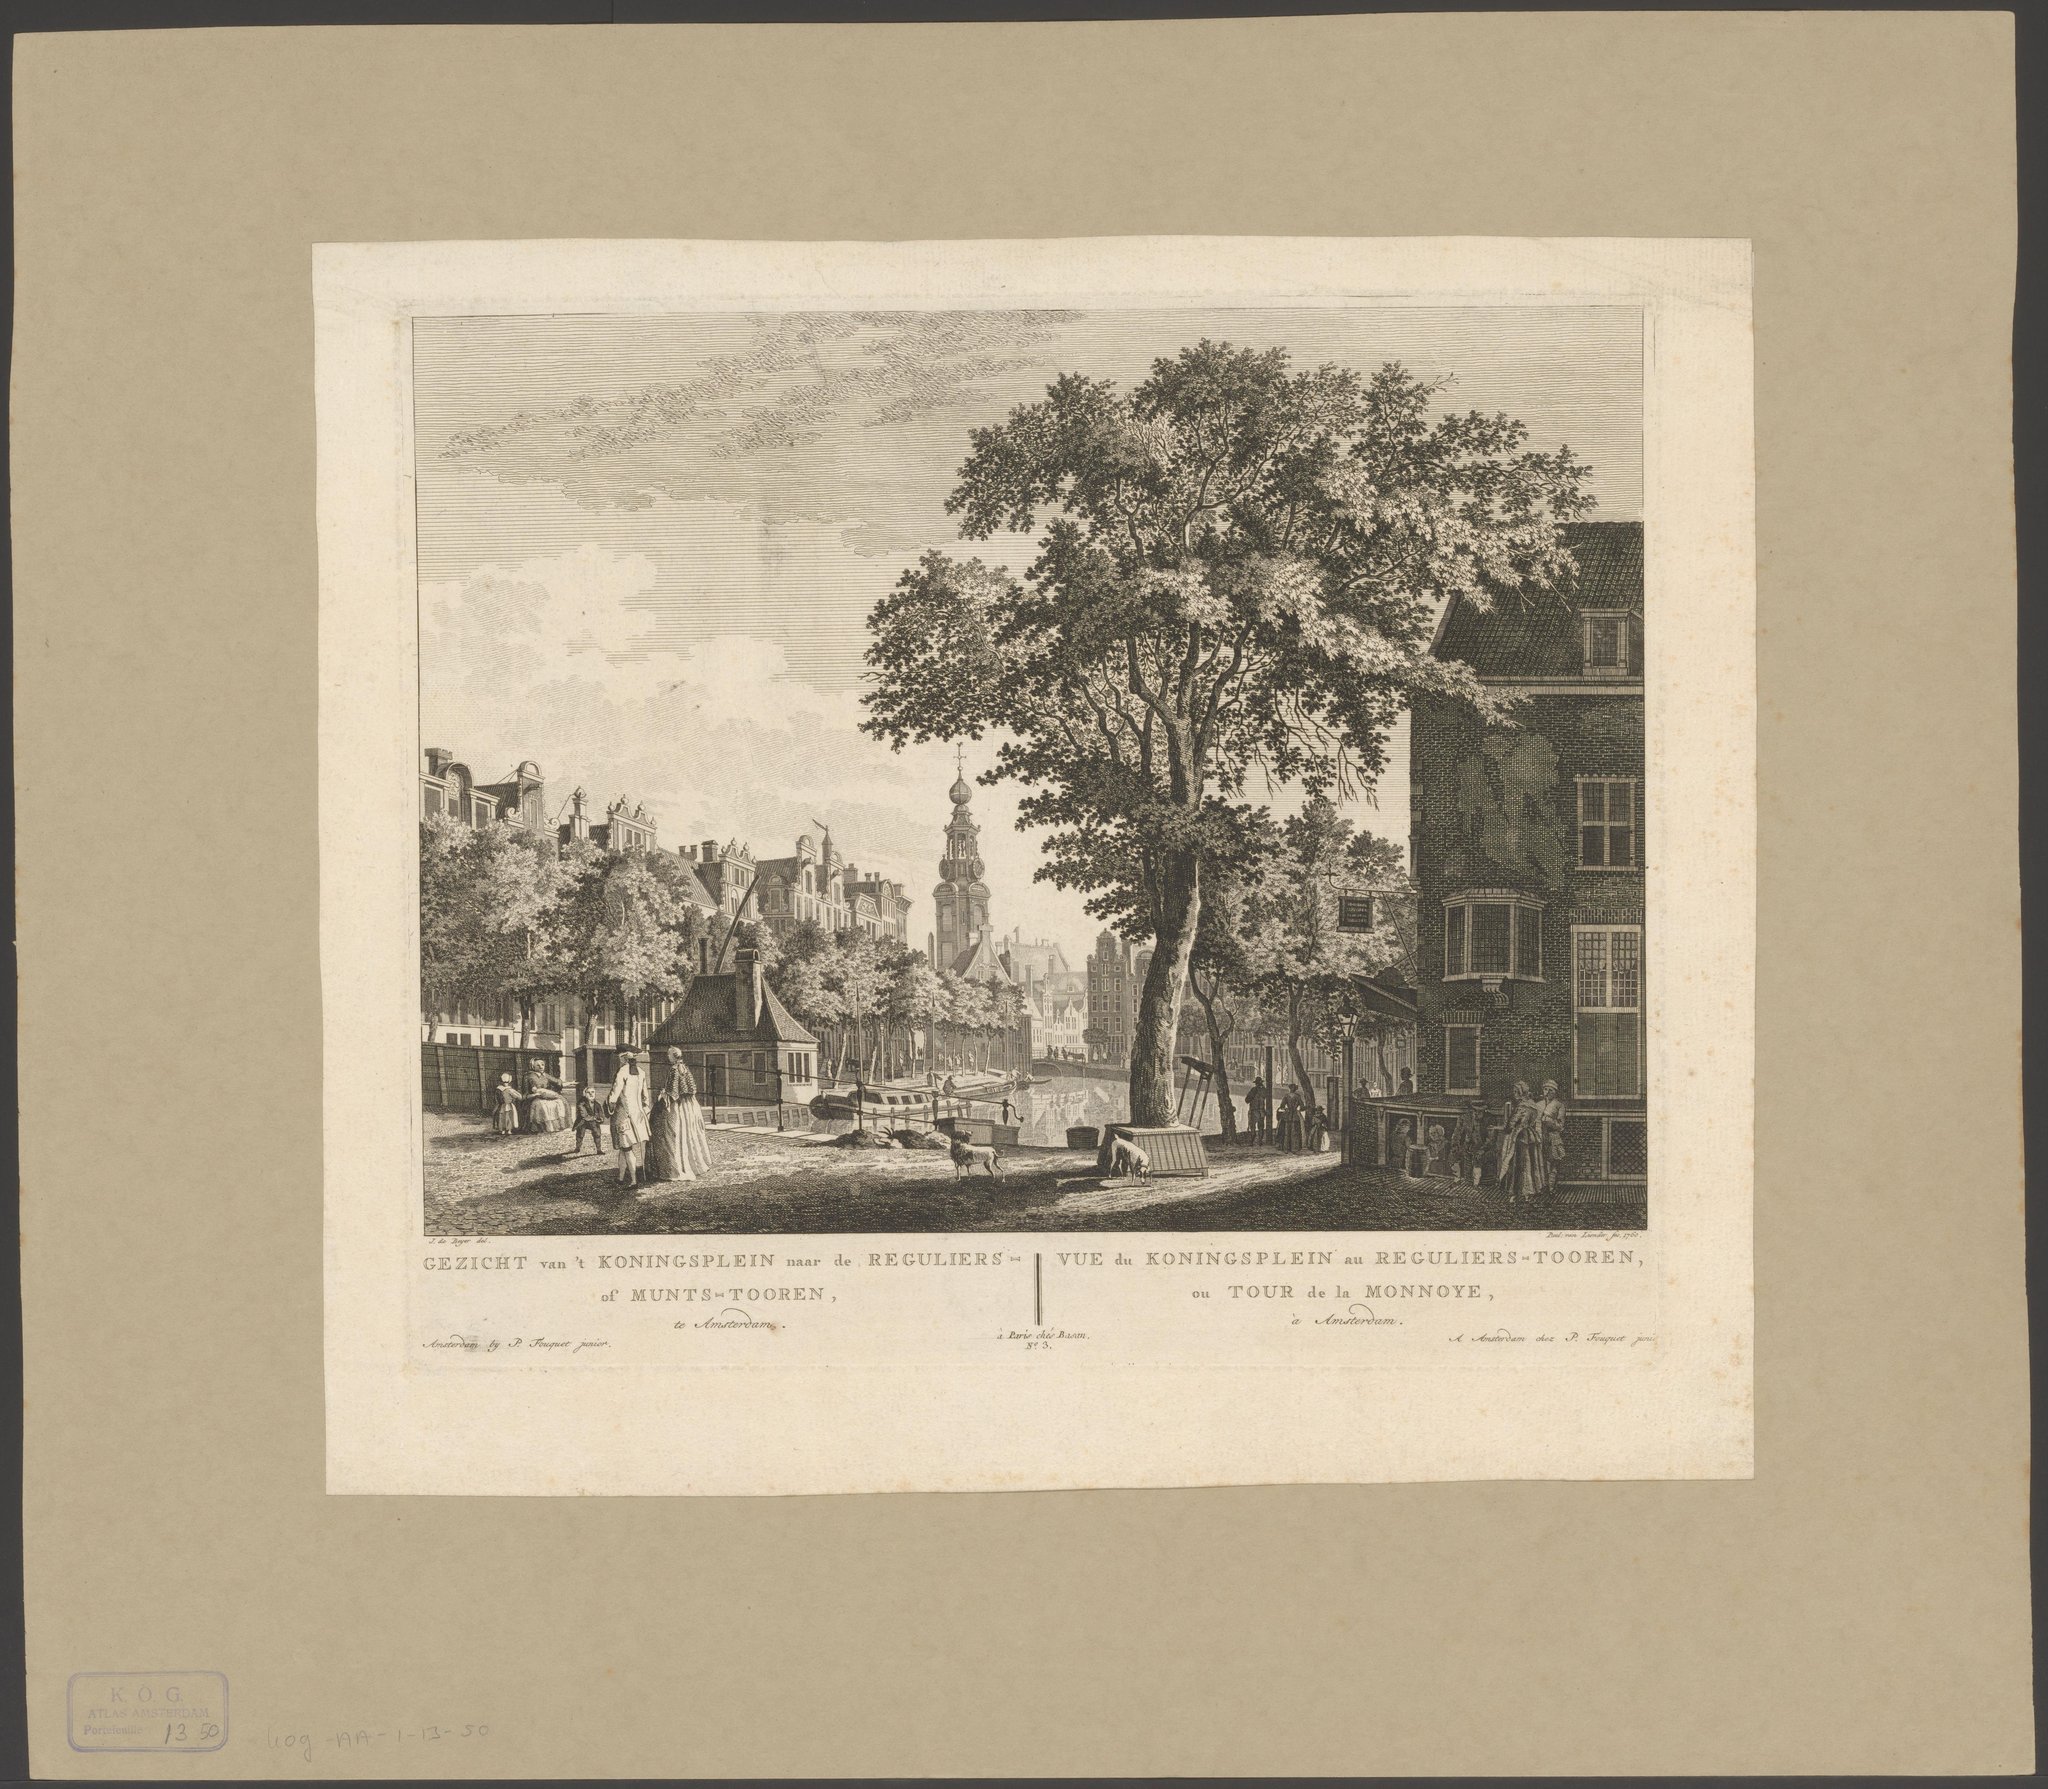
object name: print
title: Gezicht op de Munttoren van het Koningsplein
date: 1760-1783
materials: paper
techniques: etching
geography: amsterdam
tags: tower, clock tower ~ monumental adornment, city-view in general; 'veduta', canal, street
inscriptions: collector's mark: ‘13,50’ Lugt 1641b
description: Deze prent is ook gebruikt in de zogenaamde Atlas van Fouquet.* Pierre Fouquet gaf vanaf 1760 stadsgezichten van Amsterdam - naar tekeningen van verschillende kunstenaars, gemaakt door verschillende prentmakers - uit. Deze prenten werden aanvankelijk los of in series verkocht. Zoals toen gebruikelijk kon de koper de prenten zelf laten inbinden. Hiertoe gaf Fouquet tussen 1778 en 1783 een titelblad, plattegrond en inhoudsopgave van de tot dusver 100 uitgegeven prenten uit (1). Gezien de inhoud afhankelijk was van wat de koper had verzameld verschilt de inhoud van de verschillende bewaarde Fouquetatlassen onder deze titel sterk. Ook zijn er exemplaren bekend waar tevens andere prenten aan zijn toegevoegd. Omdat er behoefte bleek aan uitleg bij de platen werd in 1783 een nieuwe versie van de atlas uitgegeven, aangevuld met tekst en twee prenten. De aangegeven volgorde veranderde maar de platen van de al eerder uitgegeven prenten bleven ongewijzigd. Deze uitgave werd in opdracht van Fouquet gedrukt bij Daniël Jean Changuion en Petrus den Hengst (2). Een tiental platen werd bijgewerkt en verscheen, met nieuw impressum, in het vervolg van Wagenaars geschiedenis van Amsterdam, uitgeven door Petrus Conradi en Folkert van der Plaats (3). Een aantal jaar na het overlijden van Fouquet kwam Evert Maaskamp met een nieuwe uitgave van de atlas, met verbeterde tekst en toevoeging van twee prenten. Op alle platen verwijderde hij het oude en liet hij zijn eigen impressum zetten (4). De huidige staat van de prent komt voor in exemplaren van de onder (1) en (2) genoemde werken. * Onder de Atlas van Fouquet of Fouquetatlas verstaan we de hieronder vermelde publicaties (1), (2) en (4). (1). Afbeeldingen van de wyd-vermaarde koopstad Amsterdam benevens des zelvs voornaamste gebouwen en gezigten alle naar het leeven getekend / Receuil des edifices les plus considerables et des plus belles vues, de la fameuse ville d'Amsterdam, dessinées d'après nature. Amsterdam: Pierre Fouquet, 1778-1783. (2). Nieuwe atlas, van de voornaamste gebouwen en gezigten der stad Amsterdam, met derzelver beknopte beschryvingen. 2 delen. Amsterdam: Daniël Jean Changuion en Petrus den Hengst [in opdracht van Pierre Fouquet], 1783. (3). Stijl, Simon. Amsterdam, in zyne geschiedenissen, voorregten, koophandel, gebouwen, kerkenstaat, schoolen, schutterye, gilden en regeeringe, beschreeven. Om te dienen ten vervolge op het werk van Jan Wagenaar (…). 10 delen. Amsterdam en Harlingen: Petrus Conradi en Folkert van der Plaats, 1788-1801. (4). Nieuwe atlas, van de voornaamste gebouwen en gezigten der stad Amsterdam. Met derzelver beknopte beschryvingen. Amsterdam: Evert Maaskamp, 1805. * Het aantal vermelde staten is gebaseerd op het aantal gevonden staten. Mogelijk zijn er meer staten van deze prent. Zie RP-P-AO-27-31 voor eerste bekende staat. Zie RP-P-AO-27-53 en RP-P-1905-513 voor tweede bekende staat.